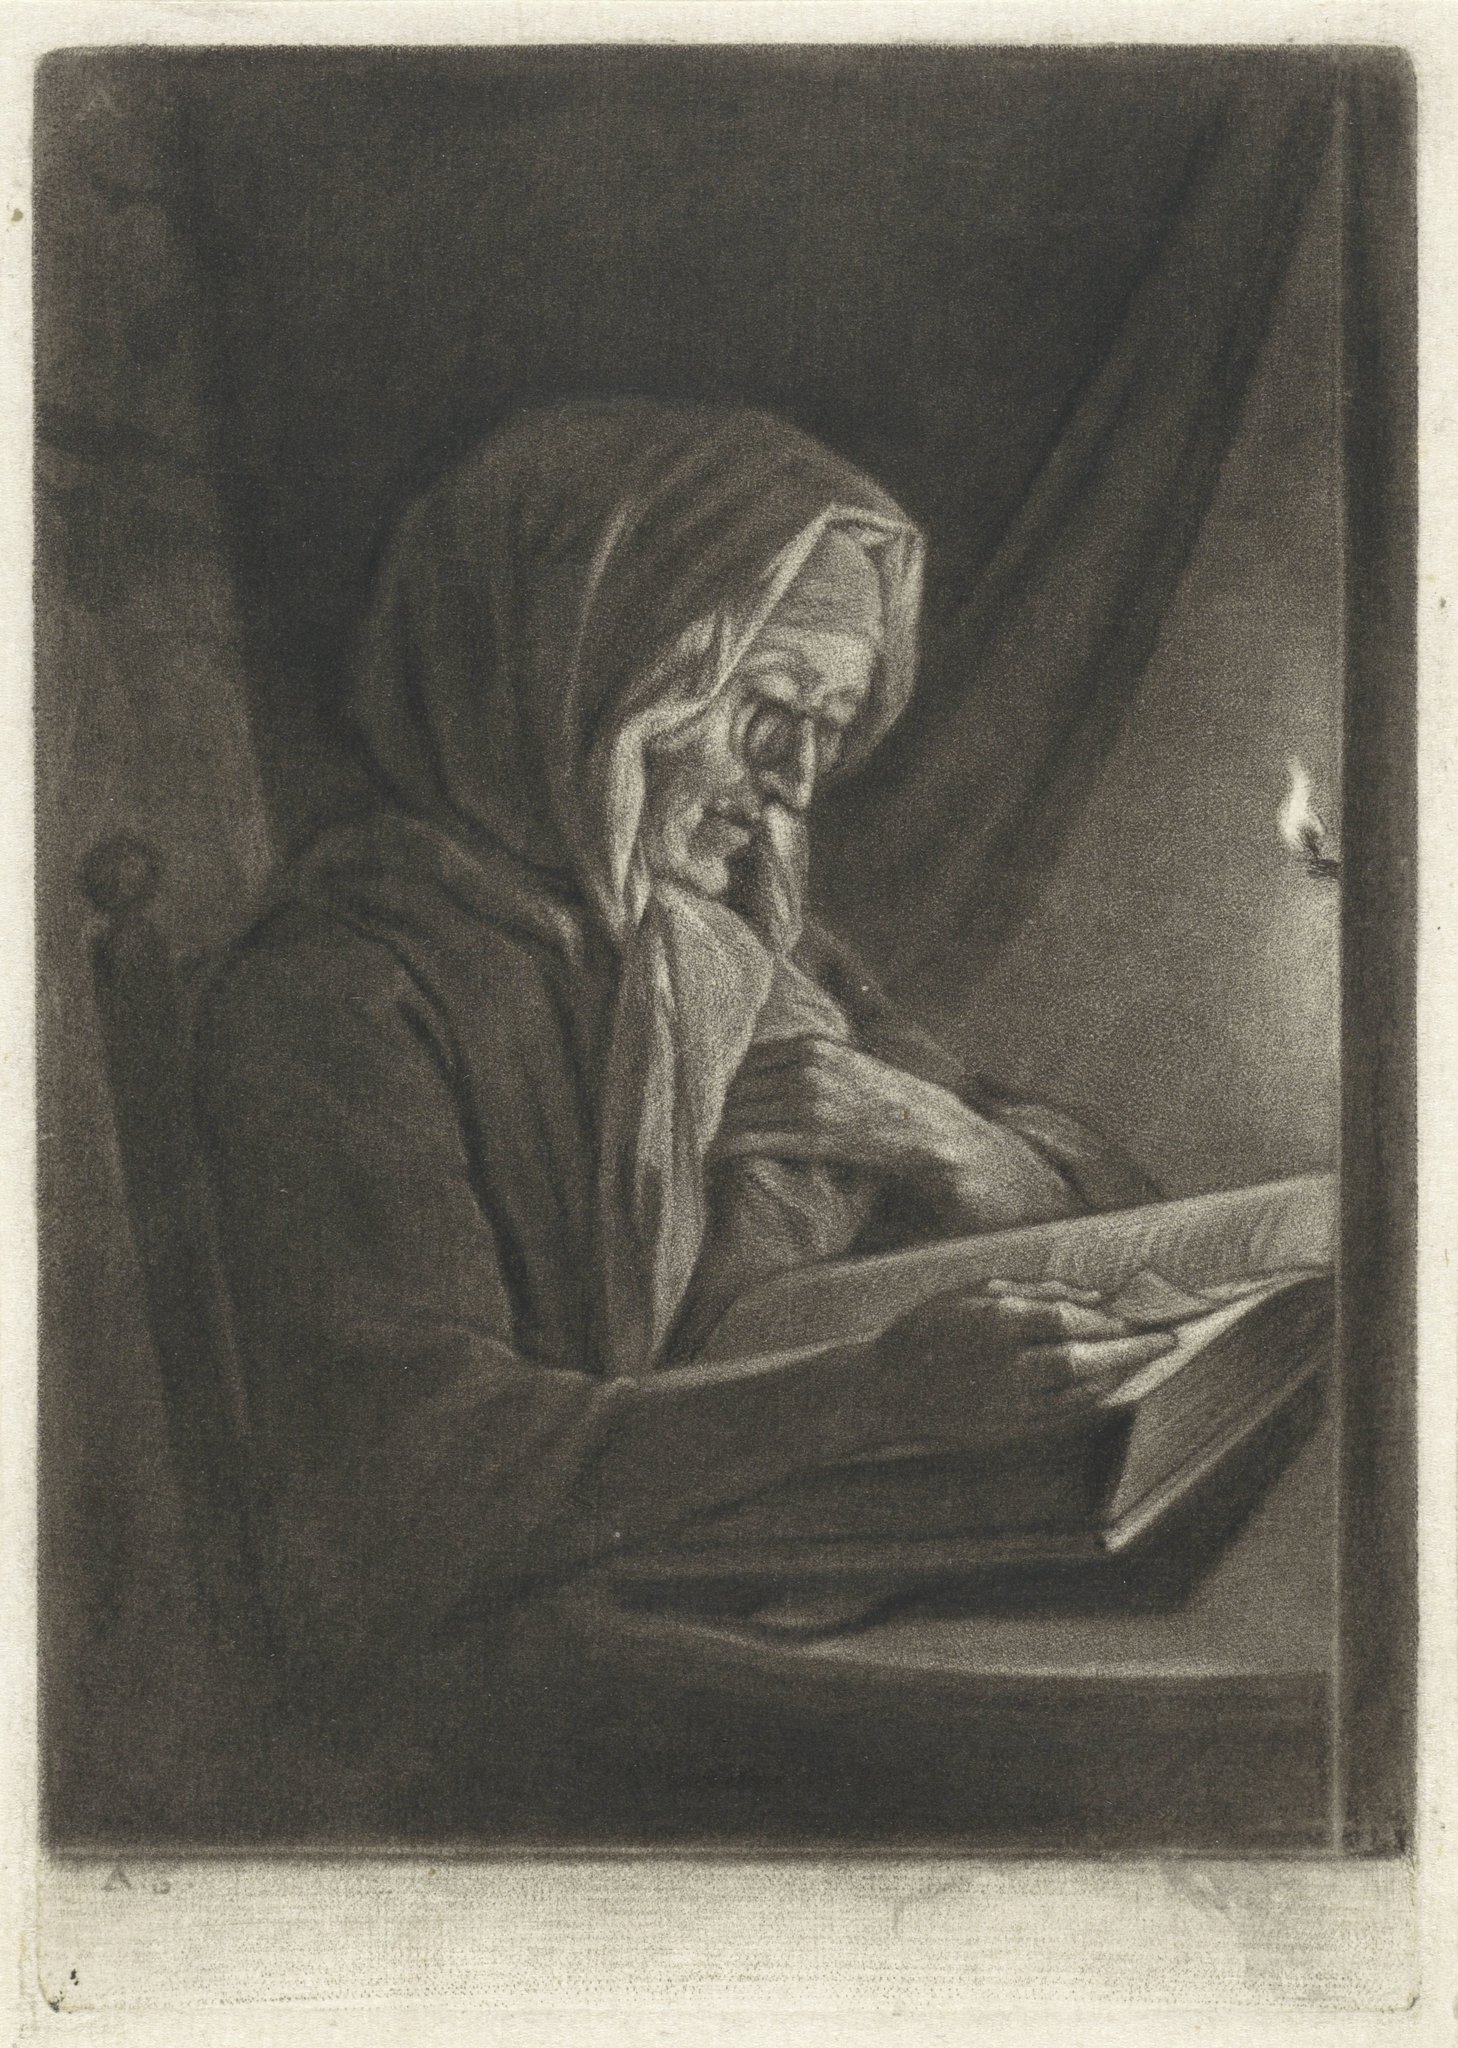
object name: print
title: Lezende vrouw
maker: aert schouman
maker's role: draughtsman, painter, print maker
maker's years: 1710-1792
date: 1720-1792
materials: paper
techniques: mezzotint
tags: eyeglasses, spectacles, reading, book - mm - book open, candle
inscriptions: collector's mark: Lugt 2228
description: Een oude vrouw leest een boek bij kaarslicht. Ze draagt een bril.